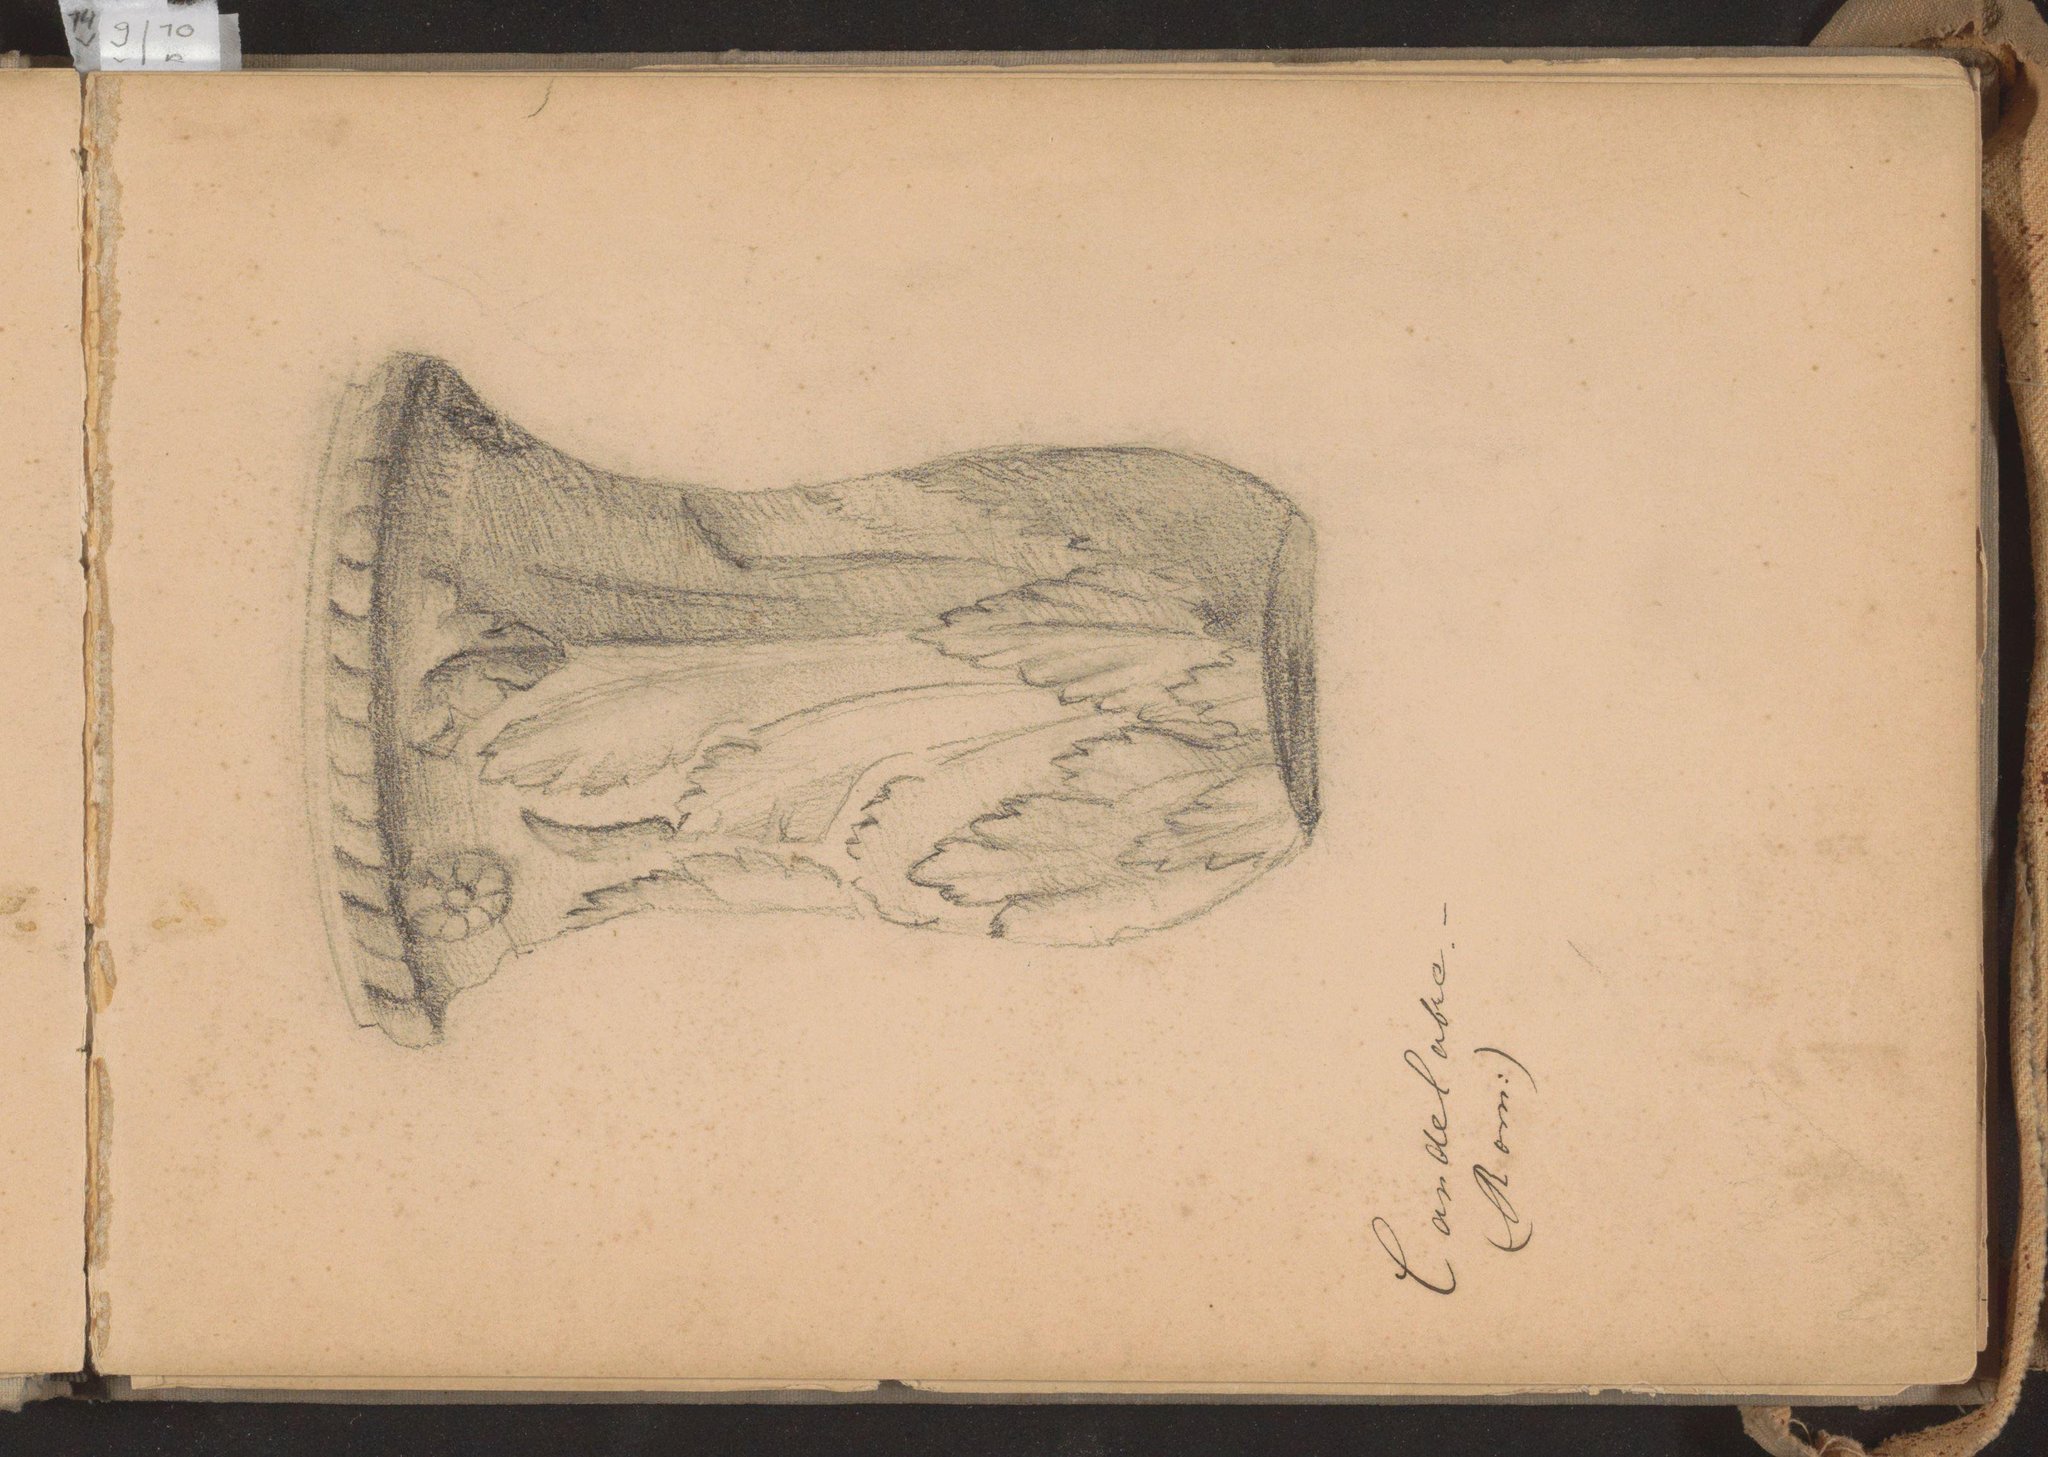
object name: sketchbook leaf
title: Romeins candelabrum gedecoreerd met bladeren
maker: johanna van de kamer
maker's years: 1873-1922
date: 1890-1922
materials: paper, pencil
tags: chandelier, candelabrum, foliage, tendrils, branches ~ ornament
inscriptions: annotation: ‘Candelabra.-/ (Rom.)’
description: Blad 7 recto uit een schetsboek met 43 bladen.